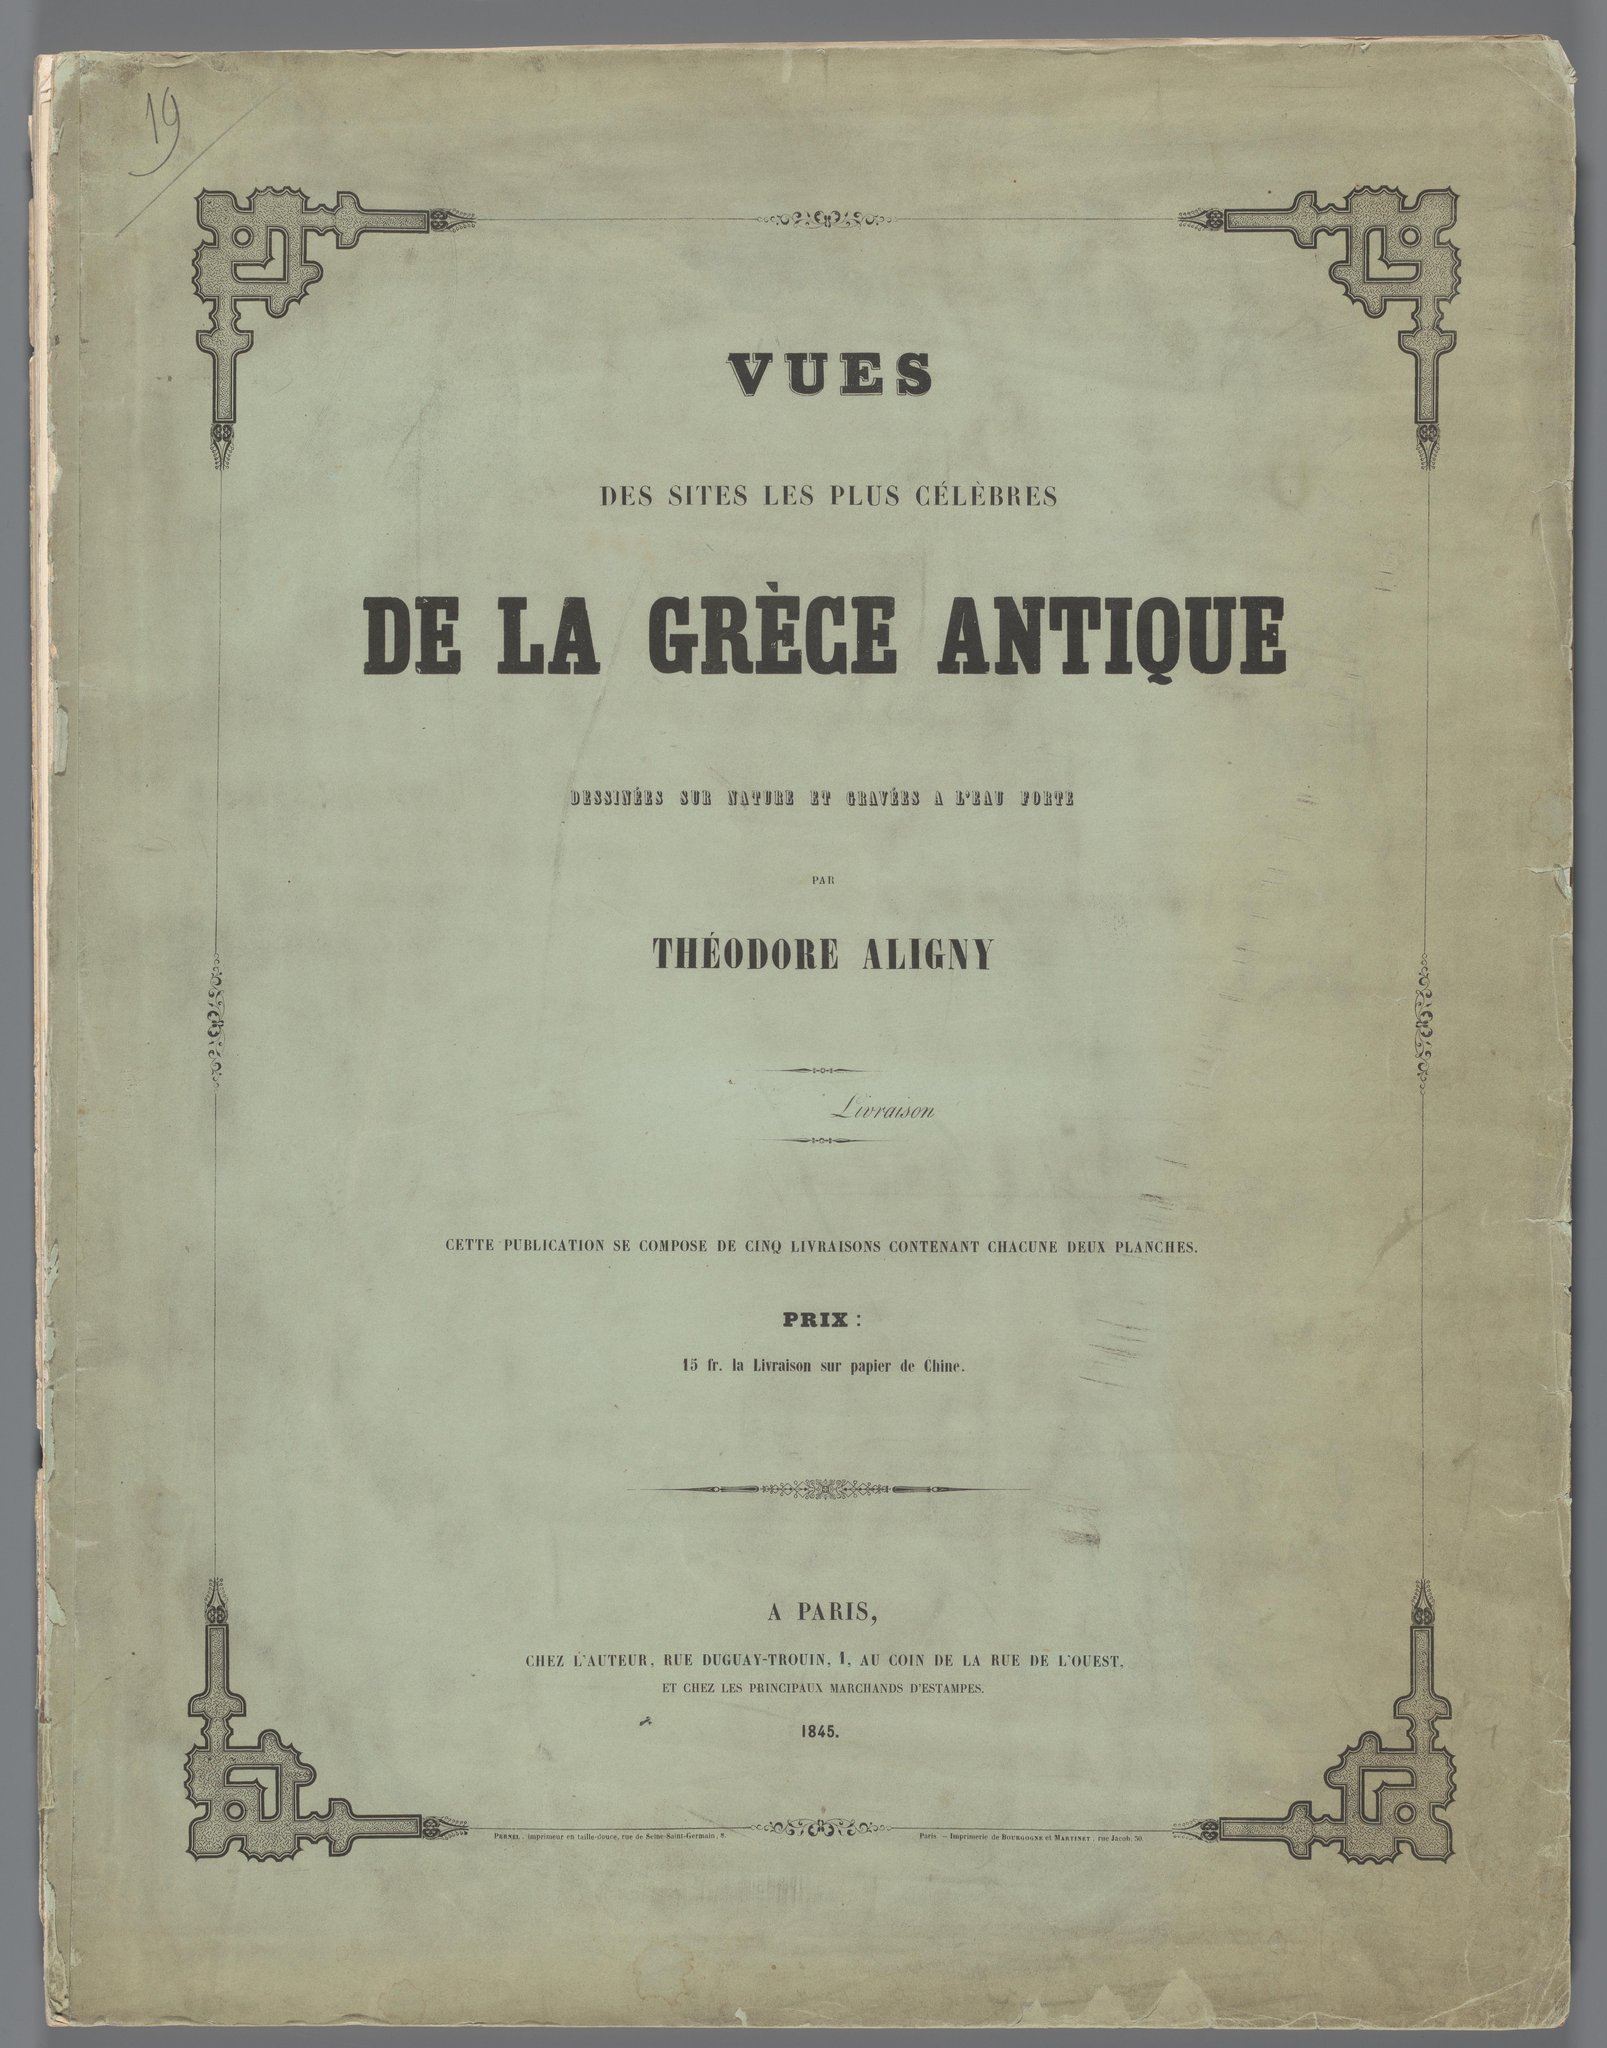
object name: wrapper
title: Omslag voor: Vues des sites les plus célèbres de la Grèce antique (...)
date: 1835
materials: paper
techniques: etching, letterpress printing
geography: paris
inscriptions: collector's mark: Lugt 2228, collector's mark: Lugt 2760